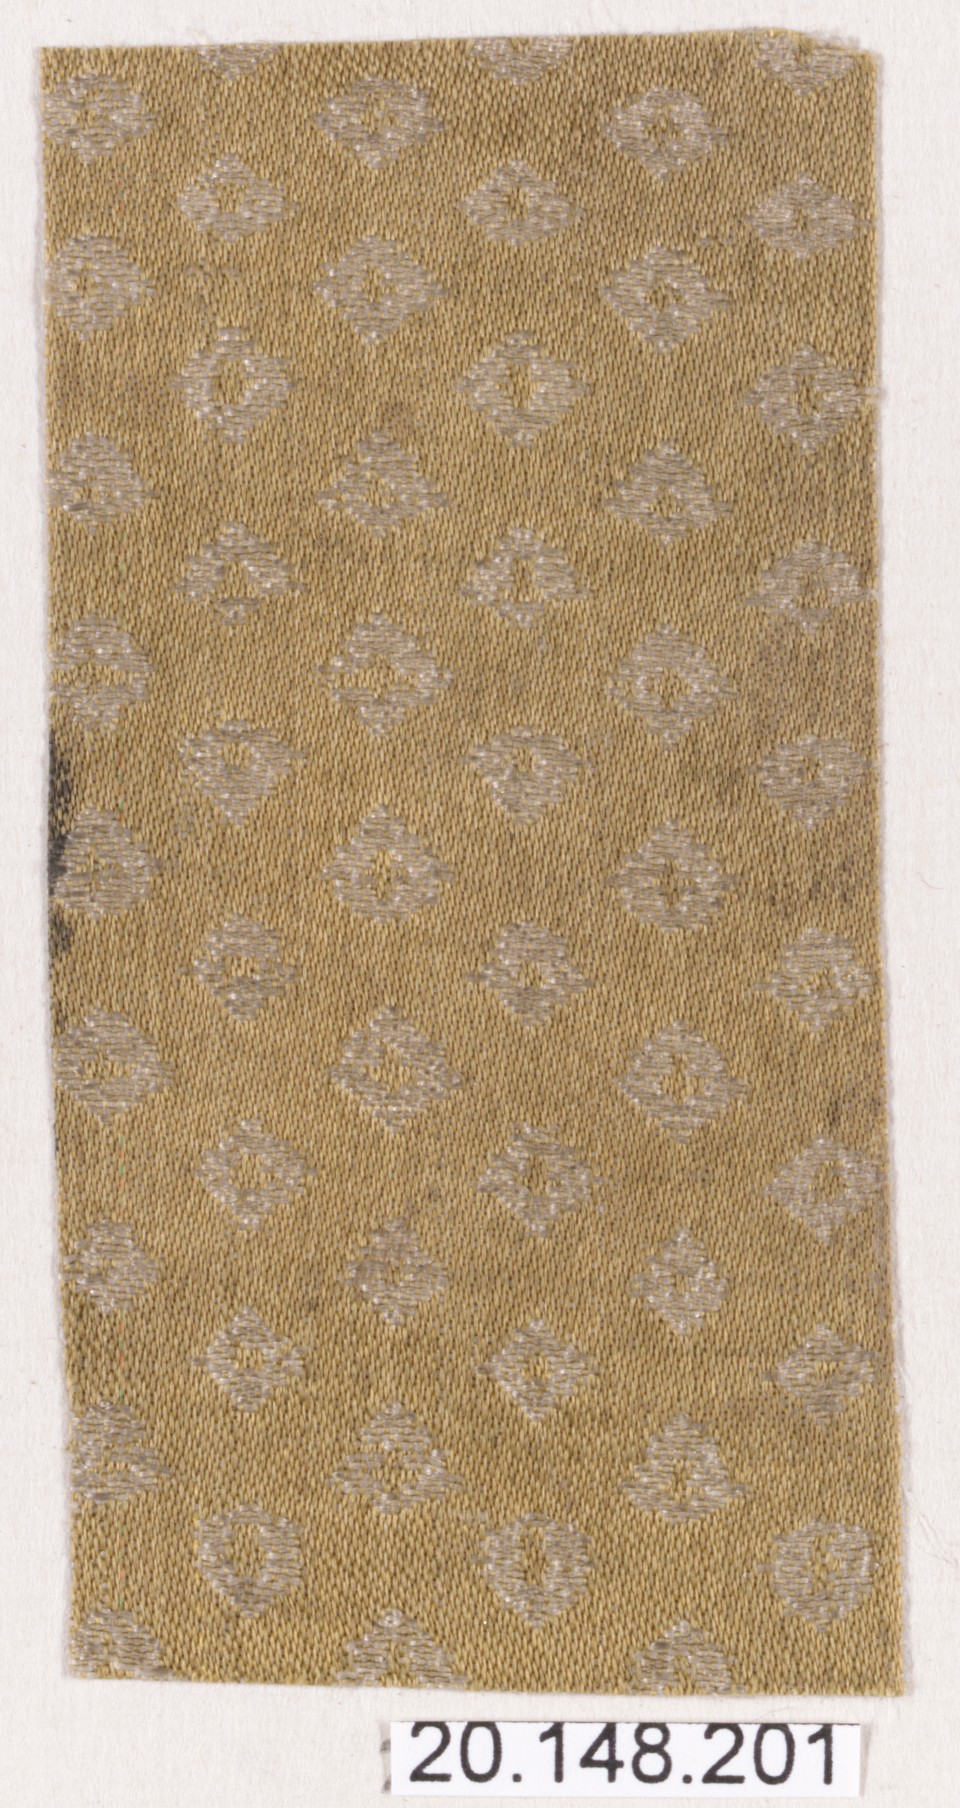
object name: piece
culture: japanese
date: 1701-1800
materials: silk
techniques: compound weave